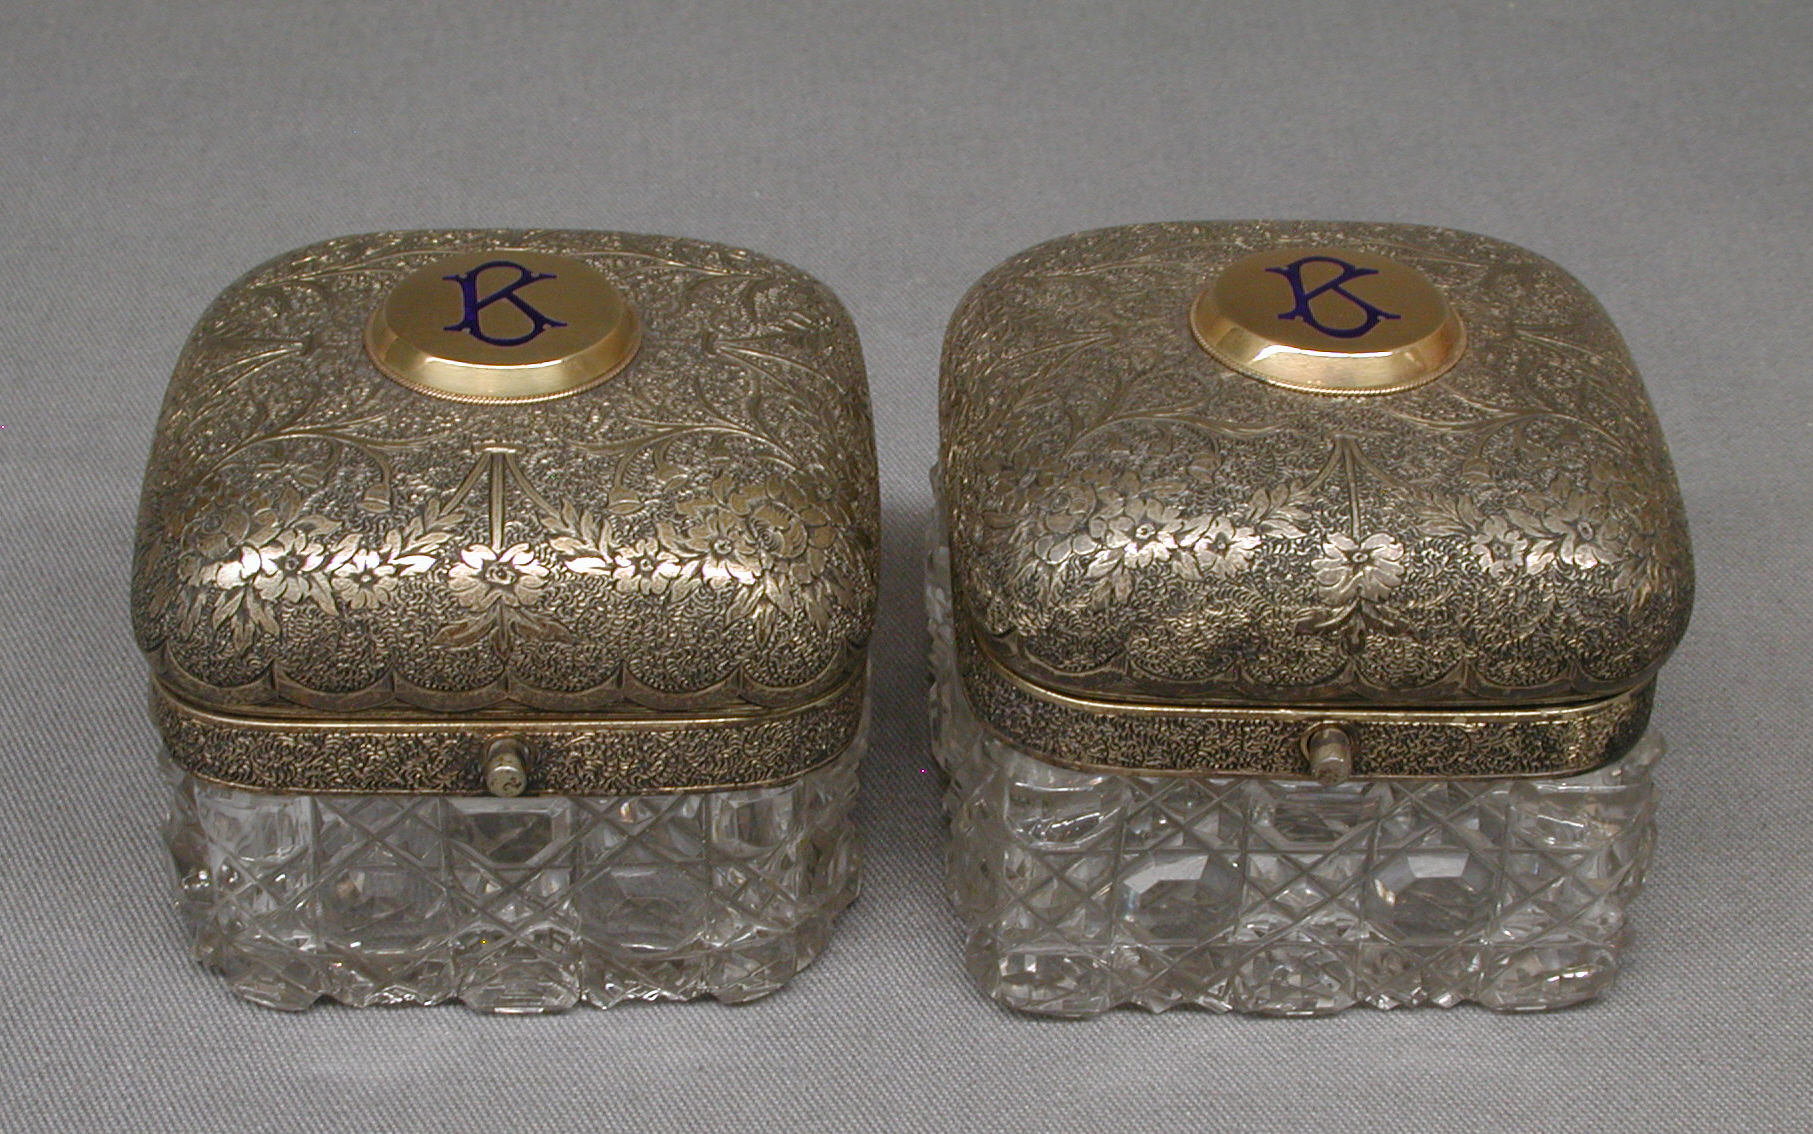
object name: cosmetic jar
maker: barnard brothers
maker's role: maker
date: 1874-1875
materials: glass, silver